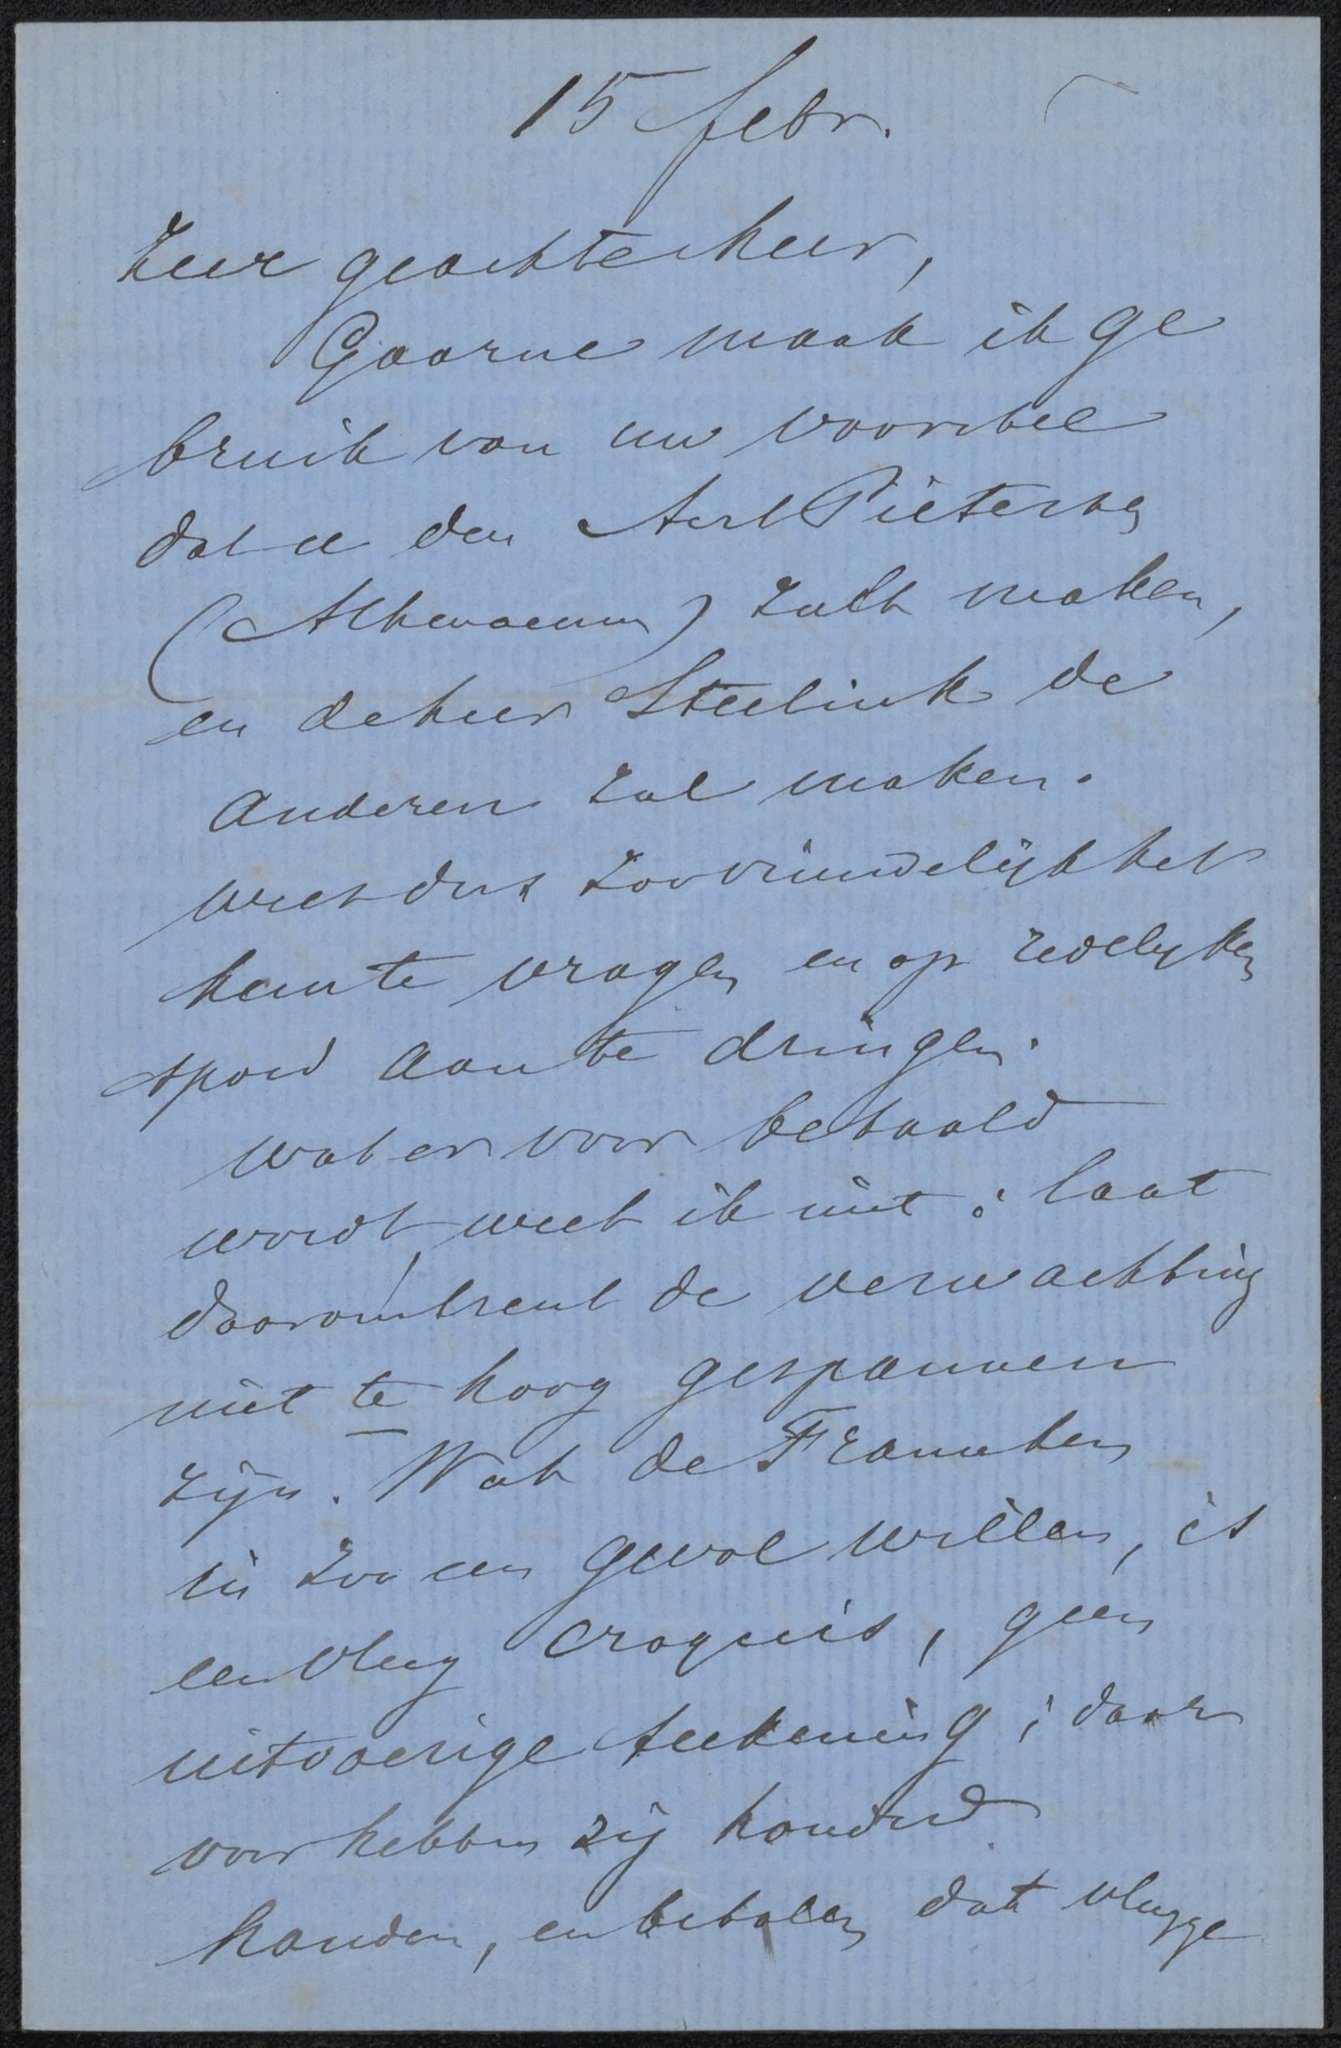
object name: letter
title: Brief aan August Allebé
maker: carel vosmaer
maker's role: draughtsman, print maker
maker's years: 1826-1888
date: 1848-1888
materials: ink, paper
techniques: pen, writing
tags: amsterdam, painter, aert pietersz., august allebé, willem steelink (ii), drawing